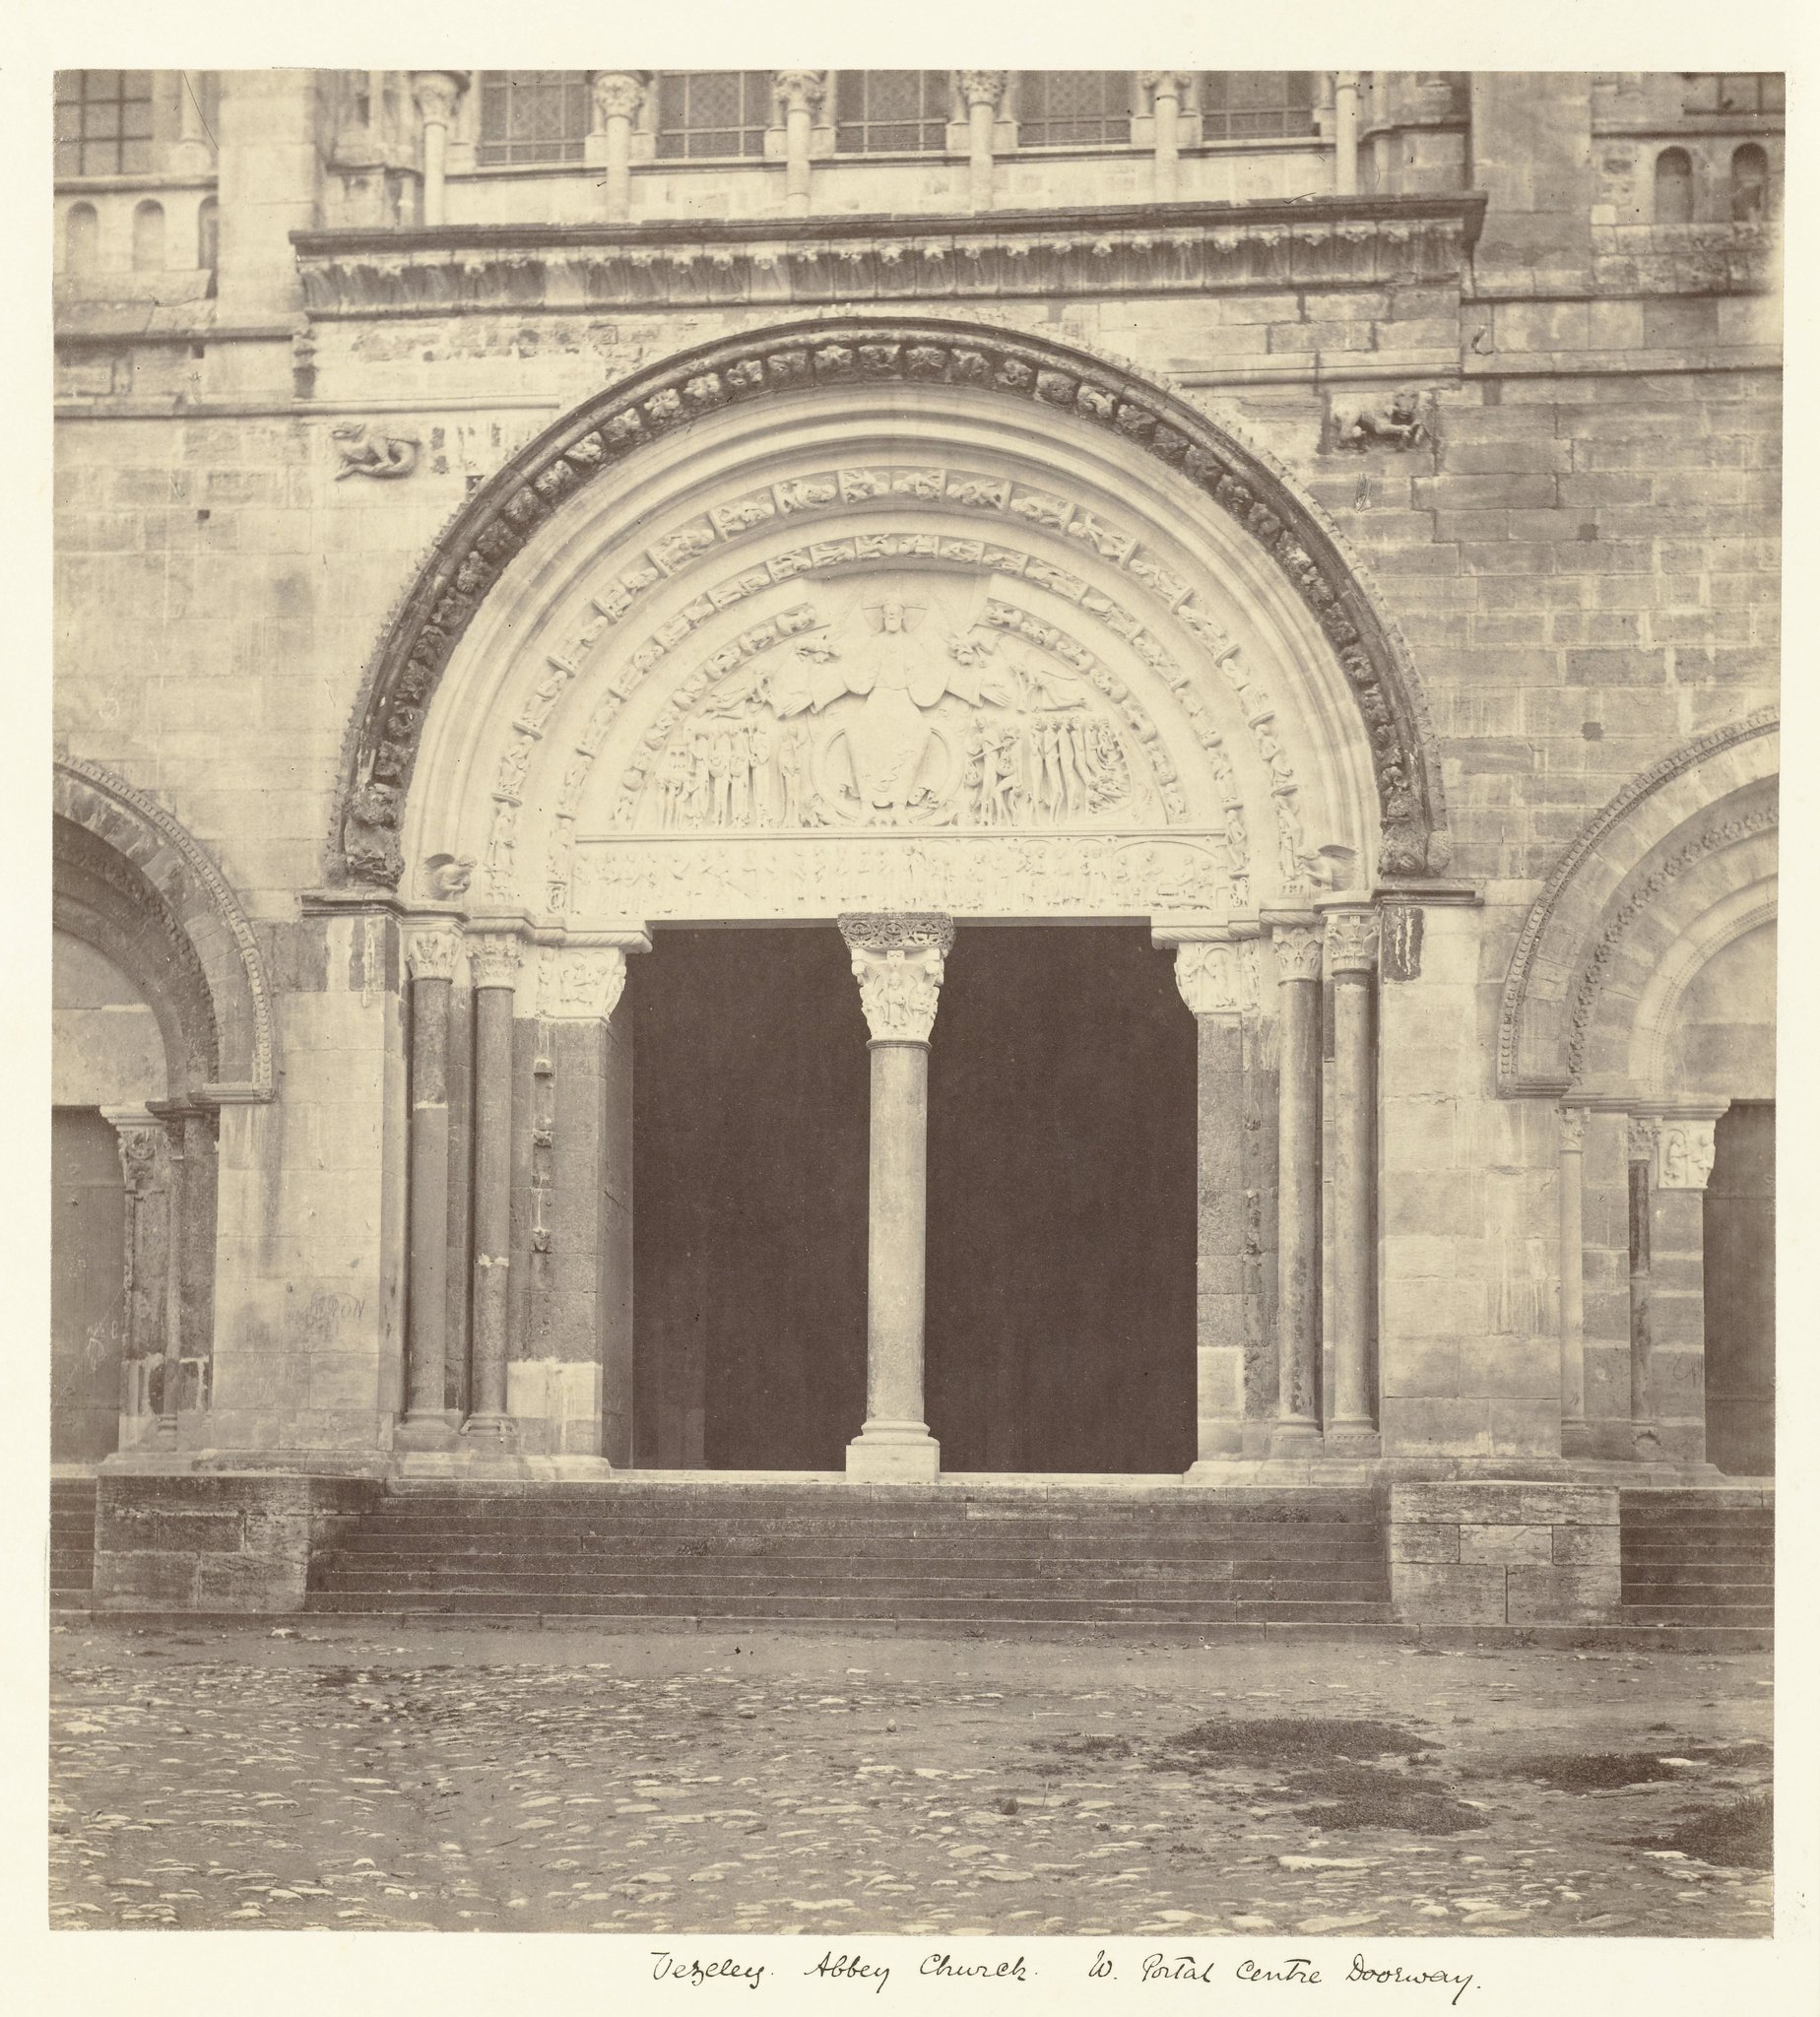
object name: photograph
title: Gezicht op de entrée van de Basiliek Sainte-Marie-Madeleine van Vézelay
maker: Anonymous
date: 1863-1865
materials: cardboard, paper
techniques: albumen print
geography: vézelay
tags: parts of church exterior and annexes: portal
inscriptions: number: ‘20.’, address: ‘[...] NEW BOND ST’